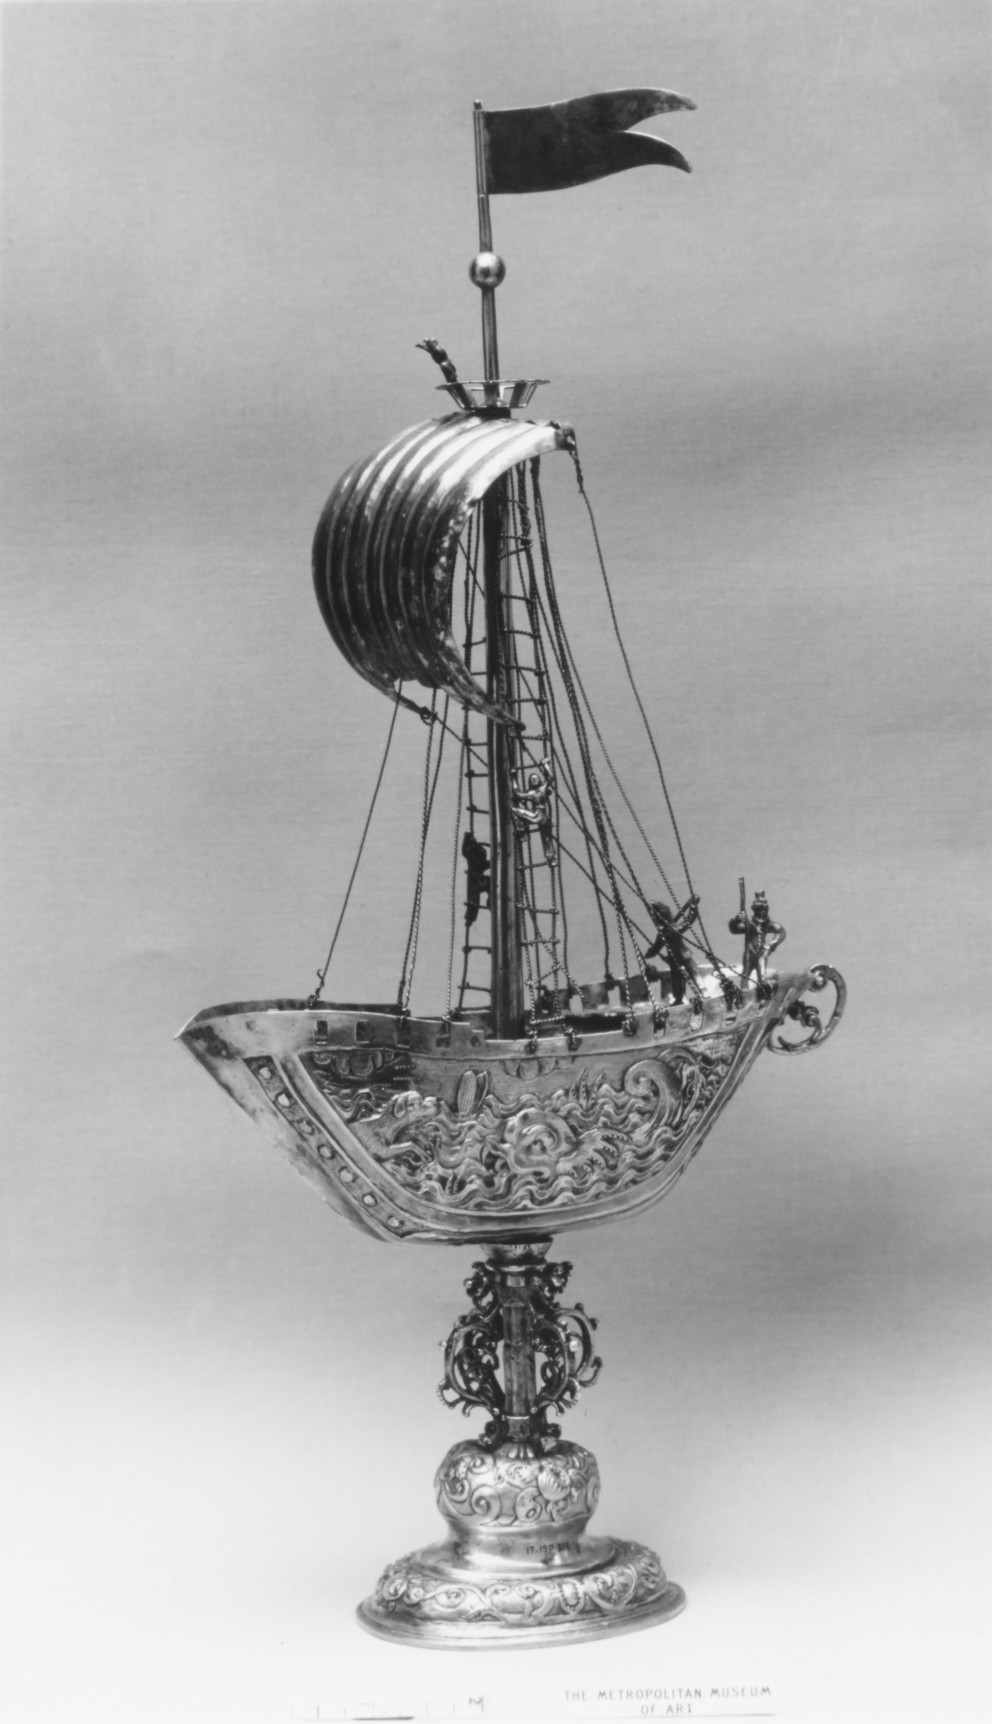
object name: figure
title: Ship (Nef)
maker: heinrich winterstein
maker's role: maker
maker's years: 1534-1634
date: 1620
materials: gilt, silver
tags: human figures,flags,ships